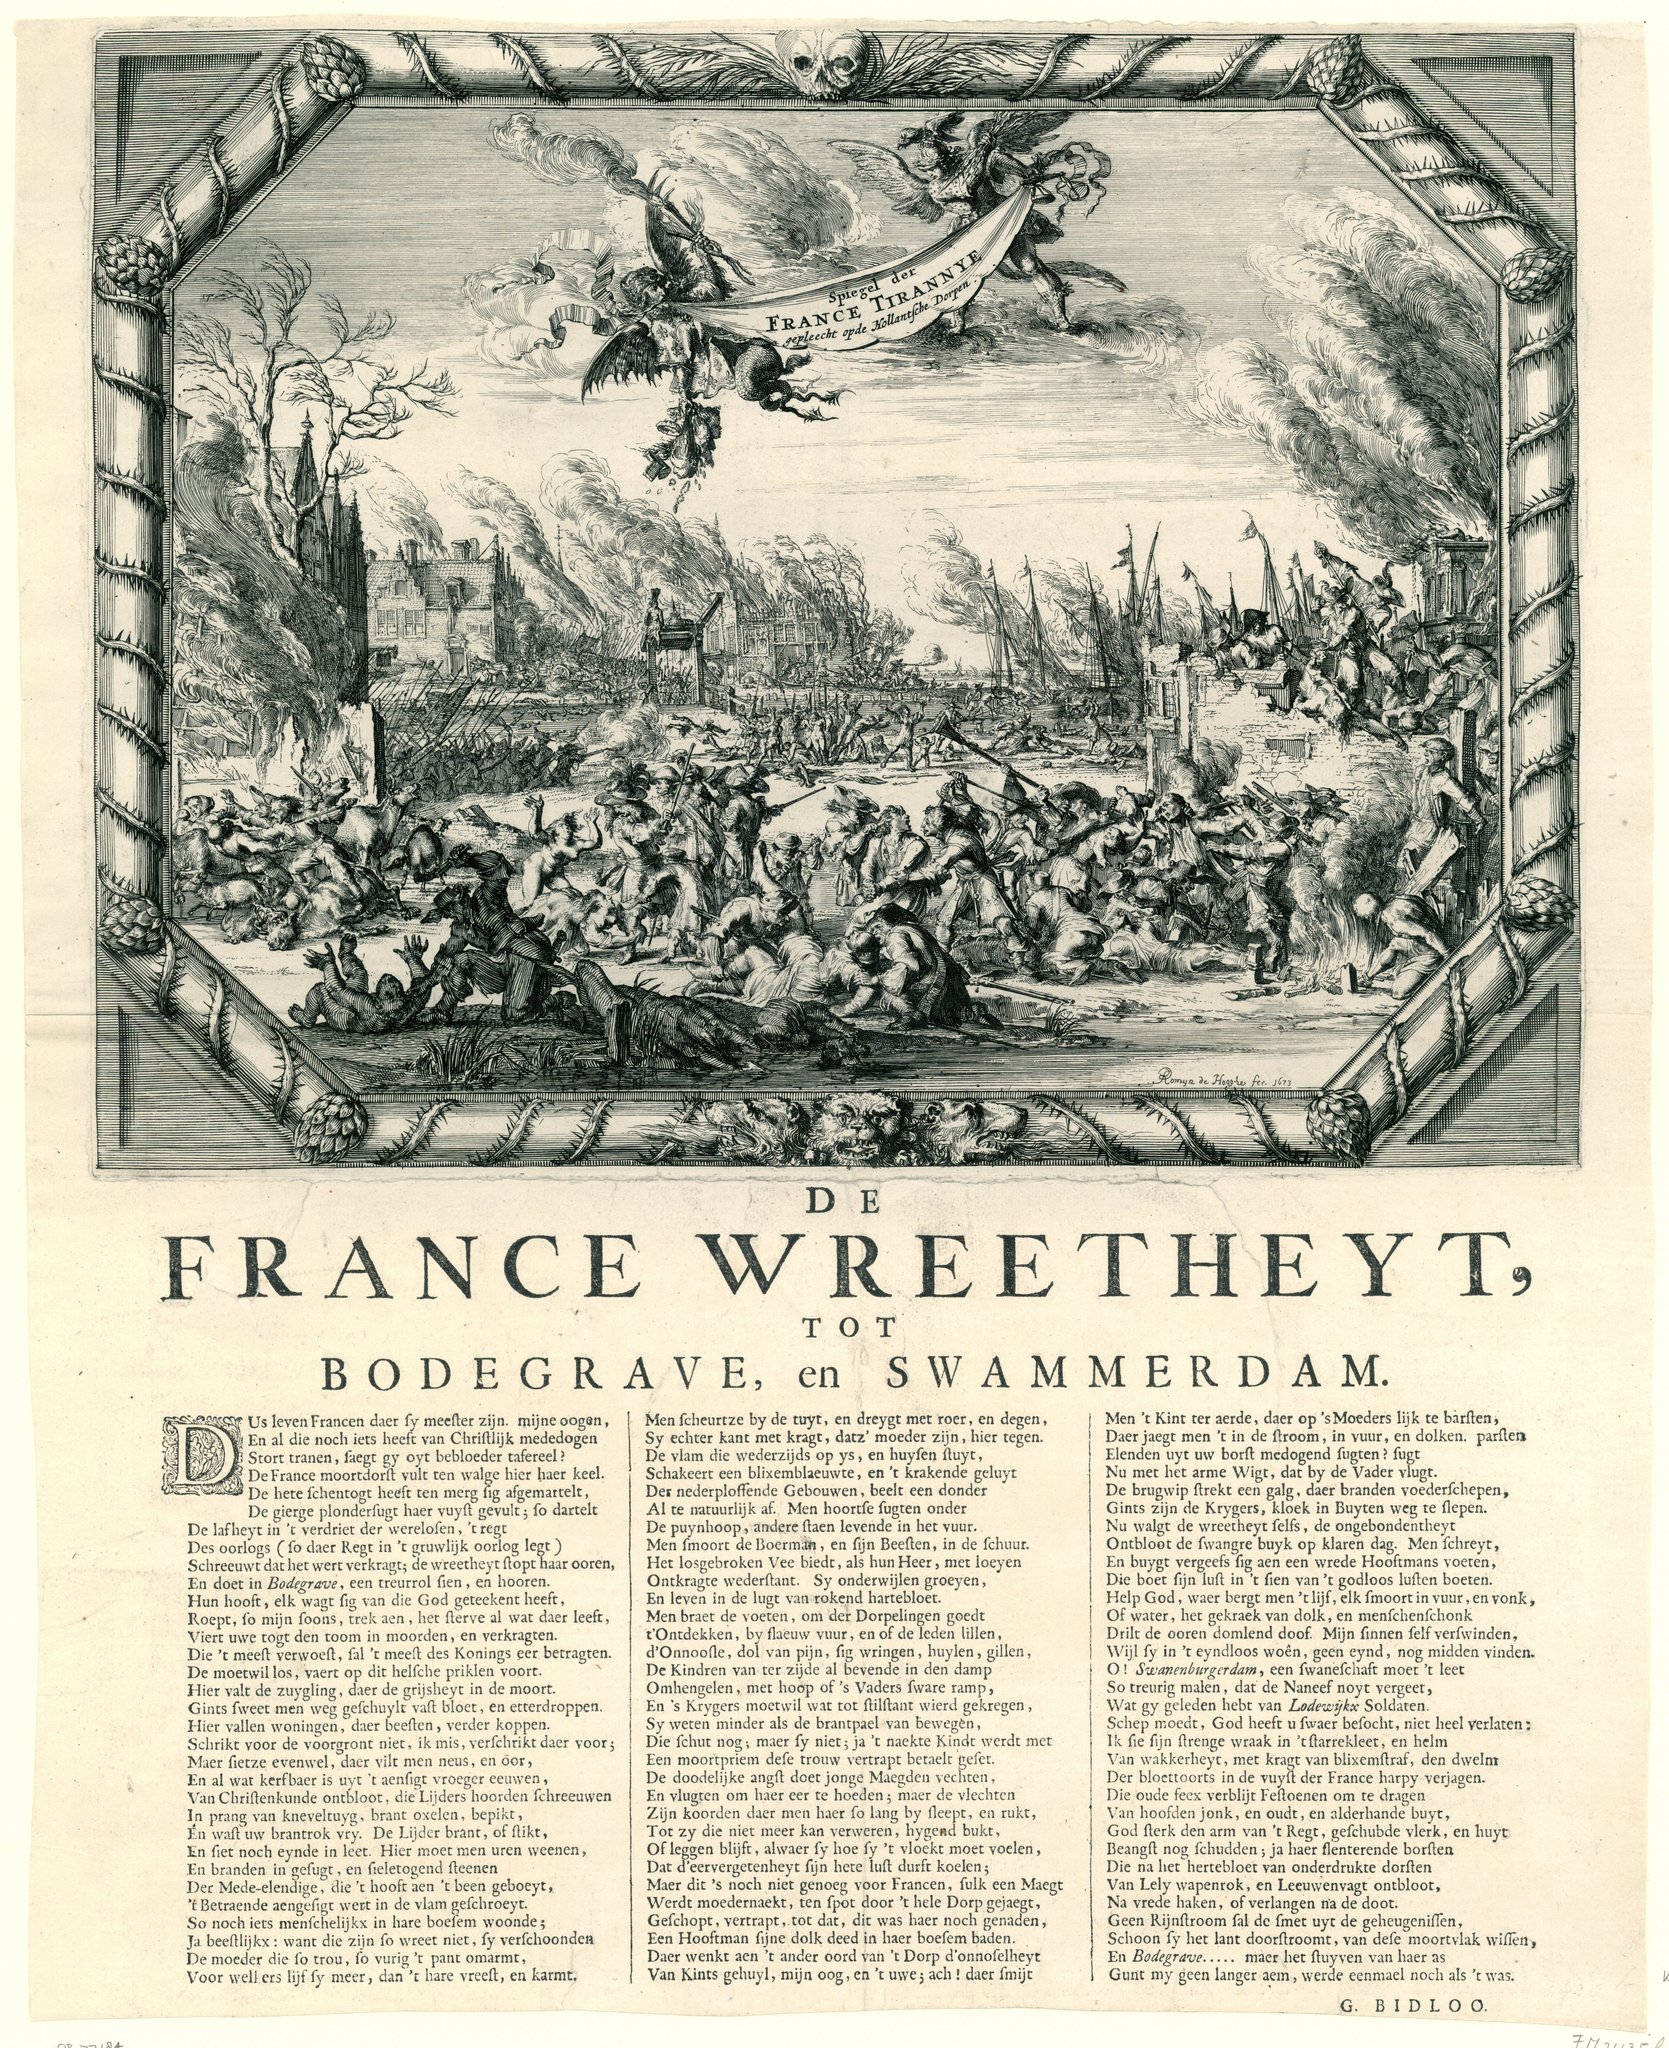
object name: print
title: Franse wreedheden in Bodegraven en Zwammerdam, 1672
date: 1673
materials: paper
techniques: engraving, etching, letterpress printing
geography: northern netherlands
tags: rape, violation, plundering ~ soldiers, violent death, being killed; being mishandled and maltreated; seeking death, massacre ~ war, bodegraven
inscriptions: date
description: Voorstelling van de wreedheden gepleegd door de Franse troepen in de Hollandse dorpen Bodegraven en Zwammerdam, eind december 1672. Het opschrift wordt in de lucht gedragen door personificaties van de oorlog en de Franse wreedheid. Links het brandende dorp Zwammerdam met de ophaalbrug. Op de voorgrond verkrachtingen, martelingen en moordpartijen. De voorstelling is gevat in een octogonale lijst, omwonden door doornen en bekroond met een doodshoofd. Latere uitgave van de prent met onder de voorstelling een vers over drie kolommen in het Nederlands van G. Bidloo over de gebeurtenissen.